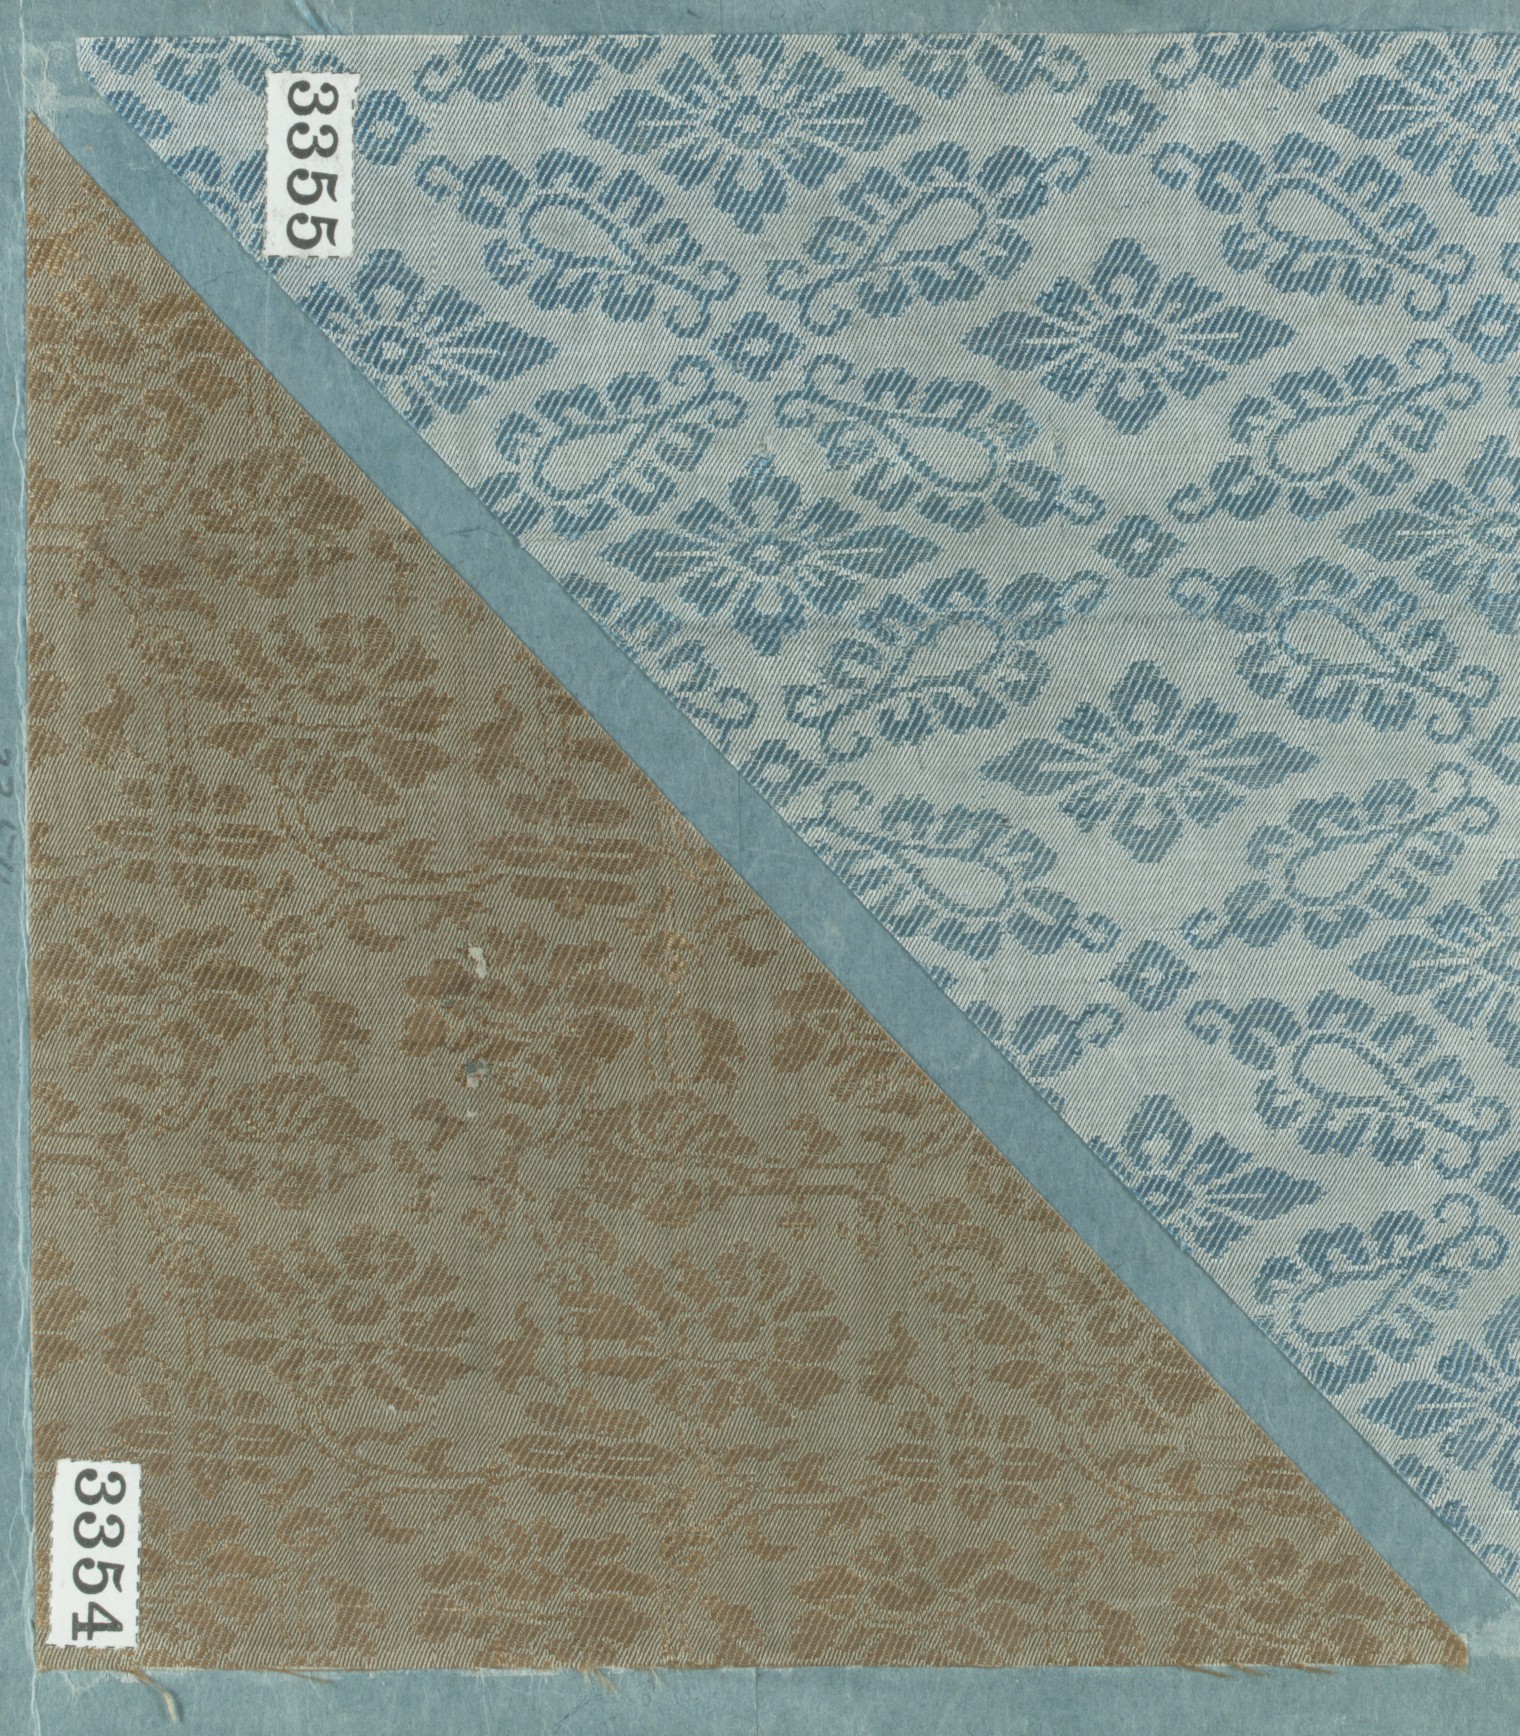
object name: textile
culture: japanese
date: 1801-1900